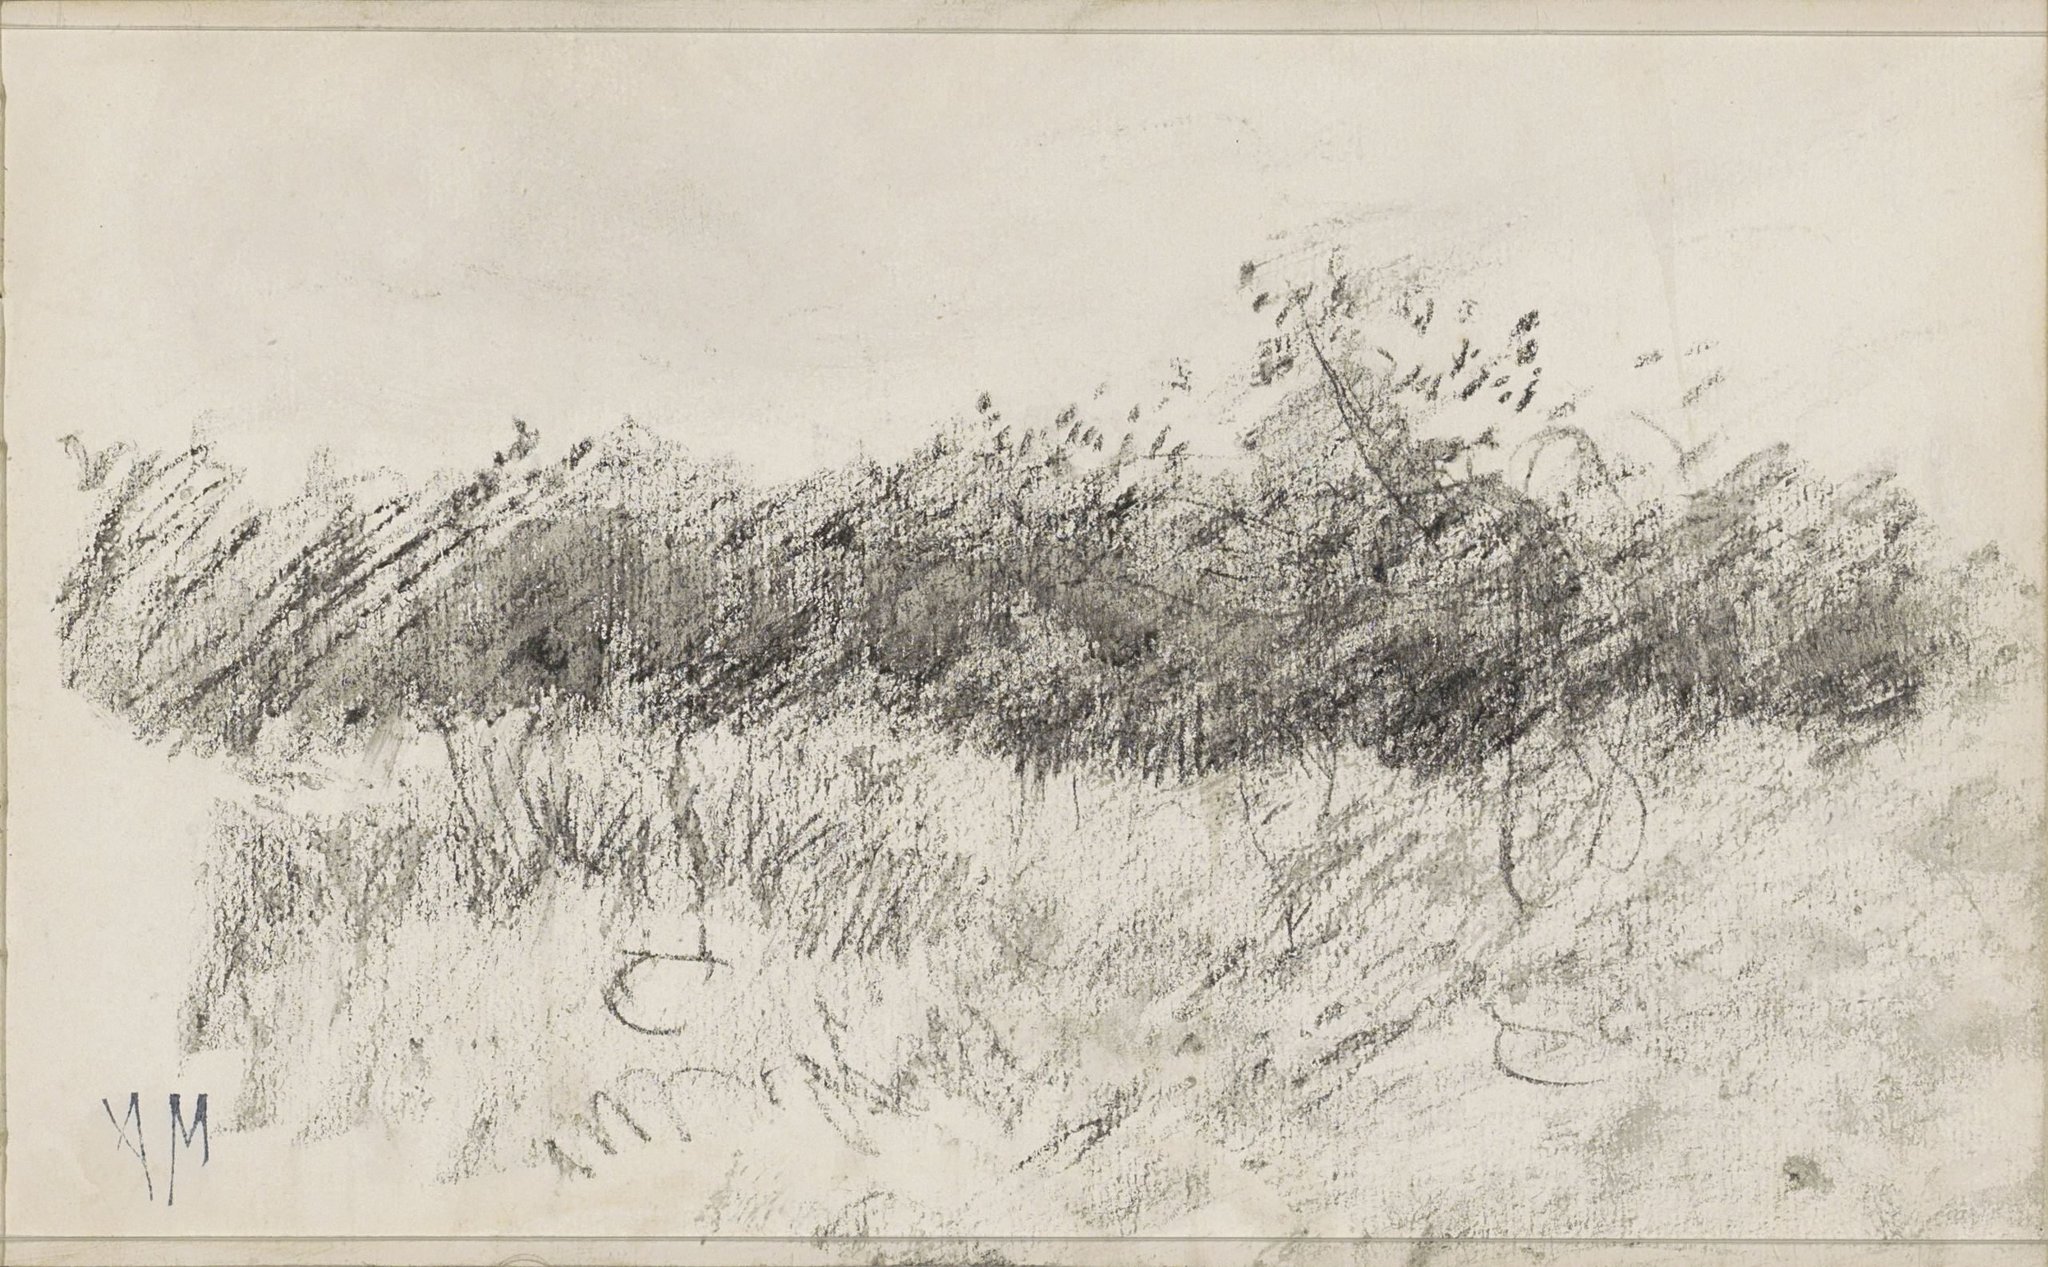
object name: sketchbook leaf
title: Landschap met gras en struiken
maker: anton mauve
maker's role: draughtsman, painter, print maker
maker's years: 1838-1888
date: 1848-1888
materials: chalk, paper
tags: landscapes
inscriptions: monogram: ‘AM’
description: Blad 13 recto uit een schetsboek met 41 bladen.